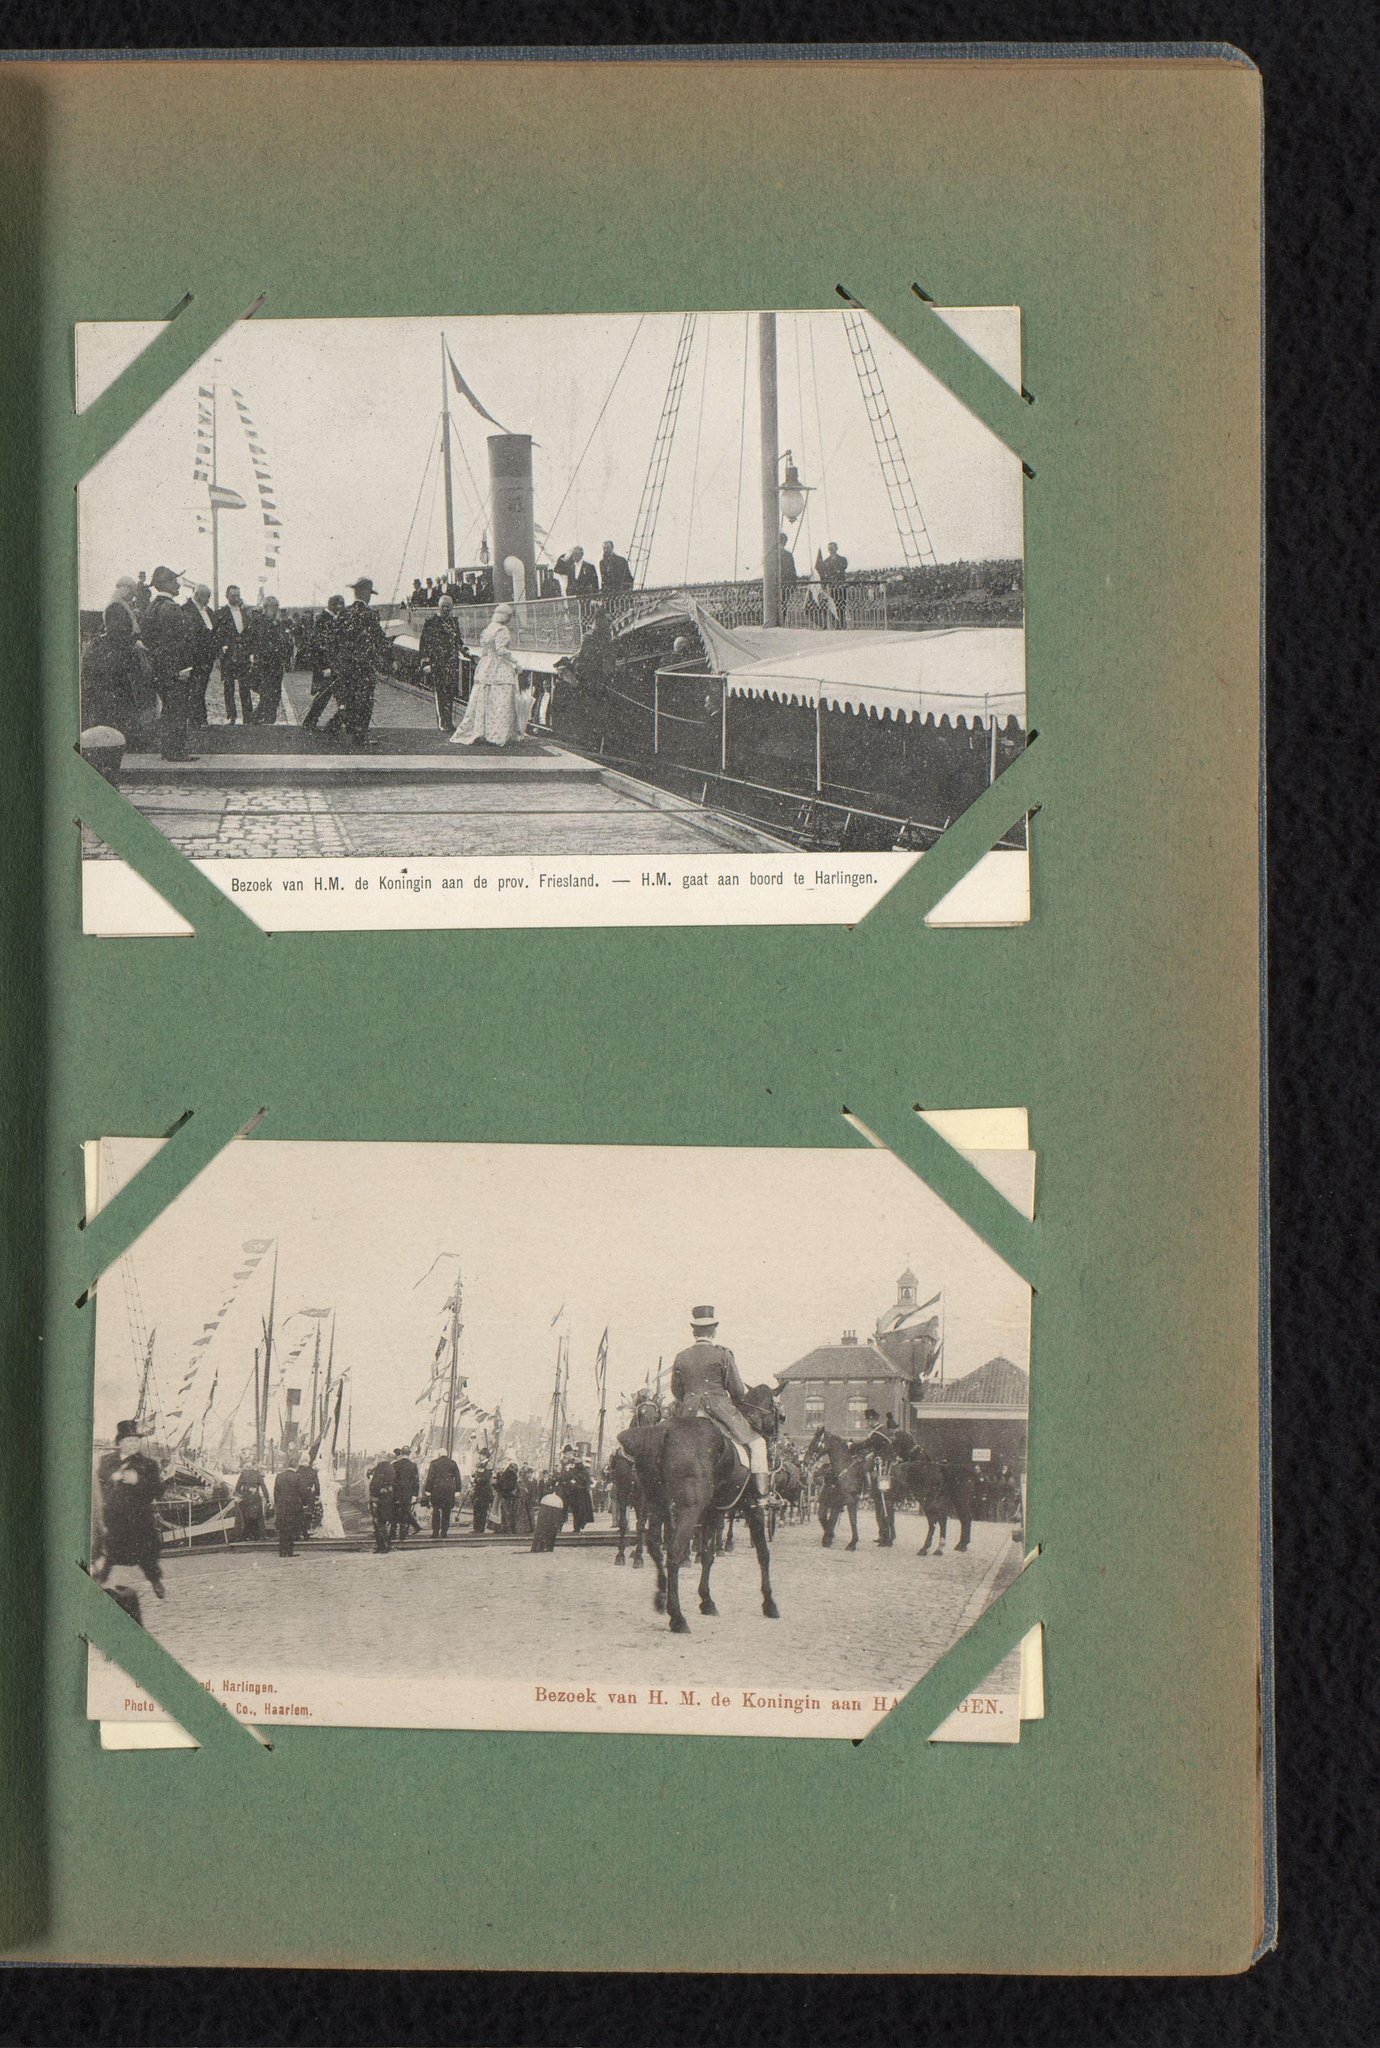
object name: photomechanical print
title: Twee prentbriefkaarten van het bezoek van koningin Wilhelmina en prins Hendrik aan Friesland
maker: Anonymous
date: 1905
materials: cardboard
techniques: photograph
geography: harlingen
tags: wilhelmina of the netherlands, the hague, hendrik (prins der nederlanden (1876-1934)), harbour, queen, harlingen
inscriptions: inscription: ‘Bezoek van H.M. de Koningin aan Harlingen.’, inscription: ‘Bezoek van H.M. de Koningin aan de prov. Friesland. - H.M. gaat aan boord te Harlingen.’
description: Deze prenten maken deel uit van een album.